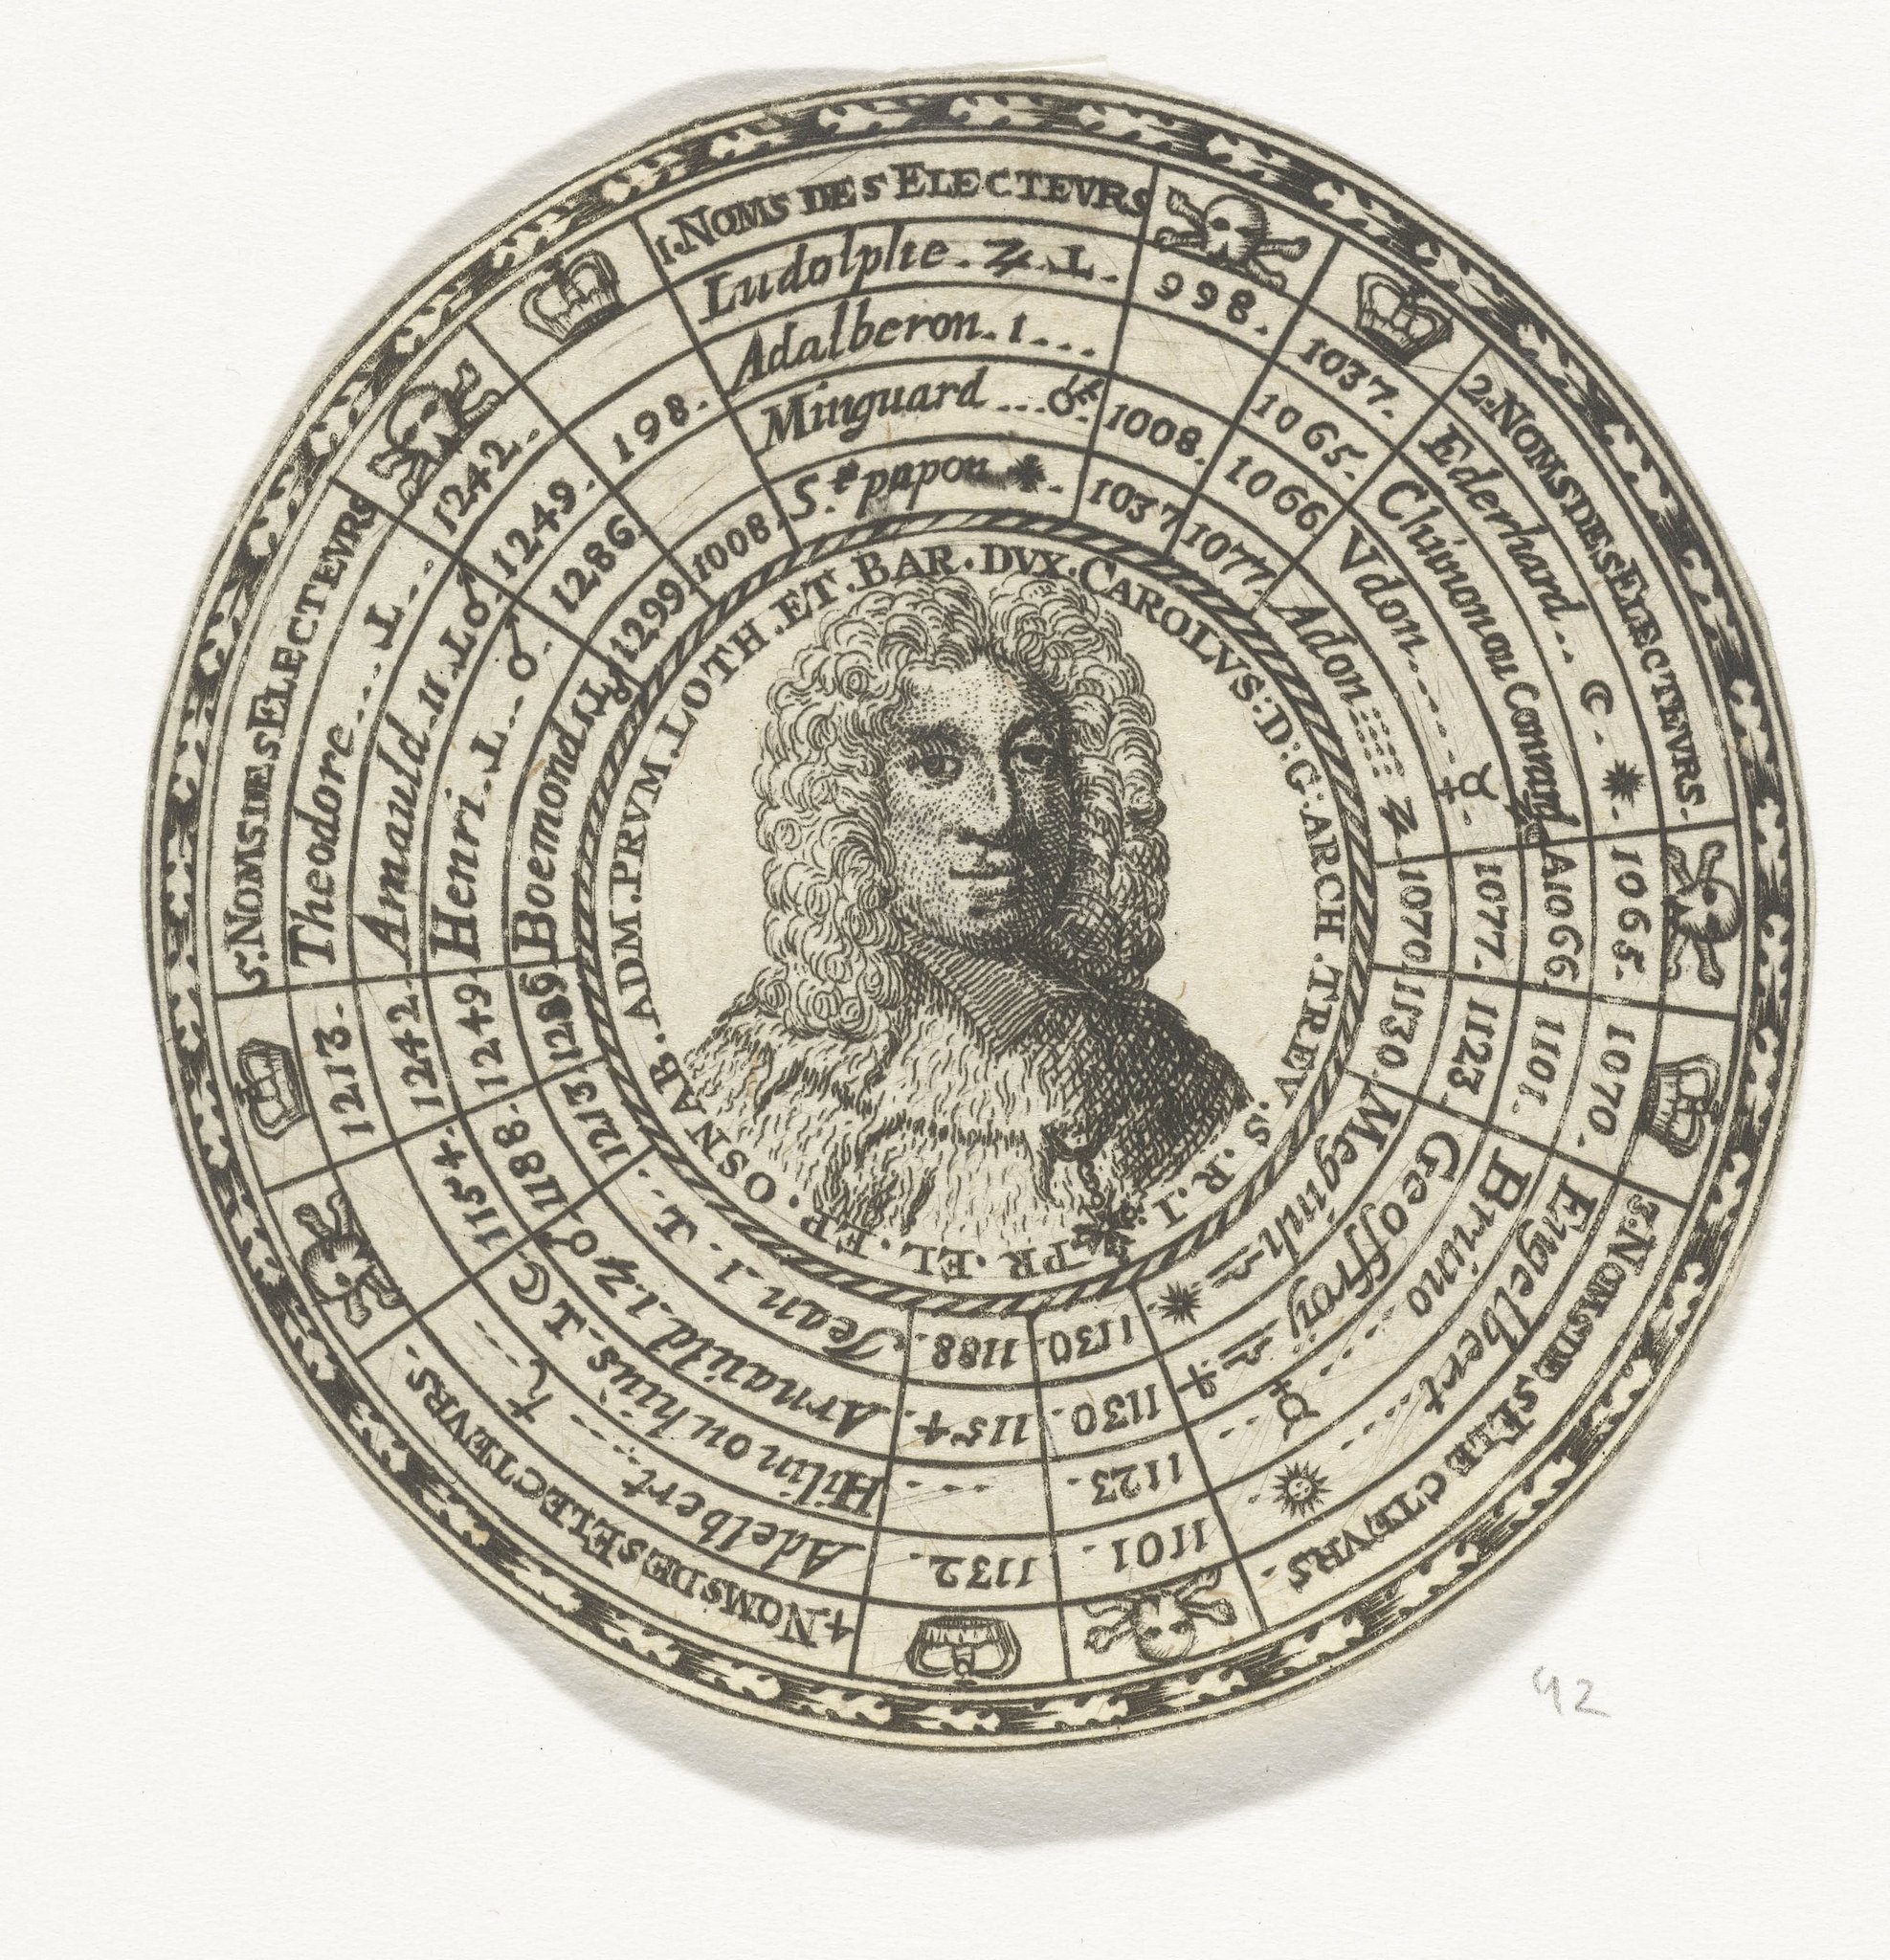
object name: print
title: Penning met het portret van aartsbisschop Johan Hugo van Orsbeck en de namen van de keurvorsten van Trier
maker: Anonymous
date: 1711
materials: paper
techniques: etching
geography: amsterdam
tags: clergyman, archbishop, bishop, etc. (roman catholic), seal (symbol of sovereignty)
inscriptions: number: ‘43’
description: Ontwerp van een ronde penning met, in vijf concentrische cirkels, de namen van de keurvorsten van Trier en hun regeringsjaren, beginnende bij aartsbisschop Ludolf en eindigend bij Bohemond. In het midden van de penning het portret van aartsbisschop Johan Hugo van Orsbeck.